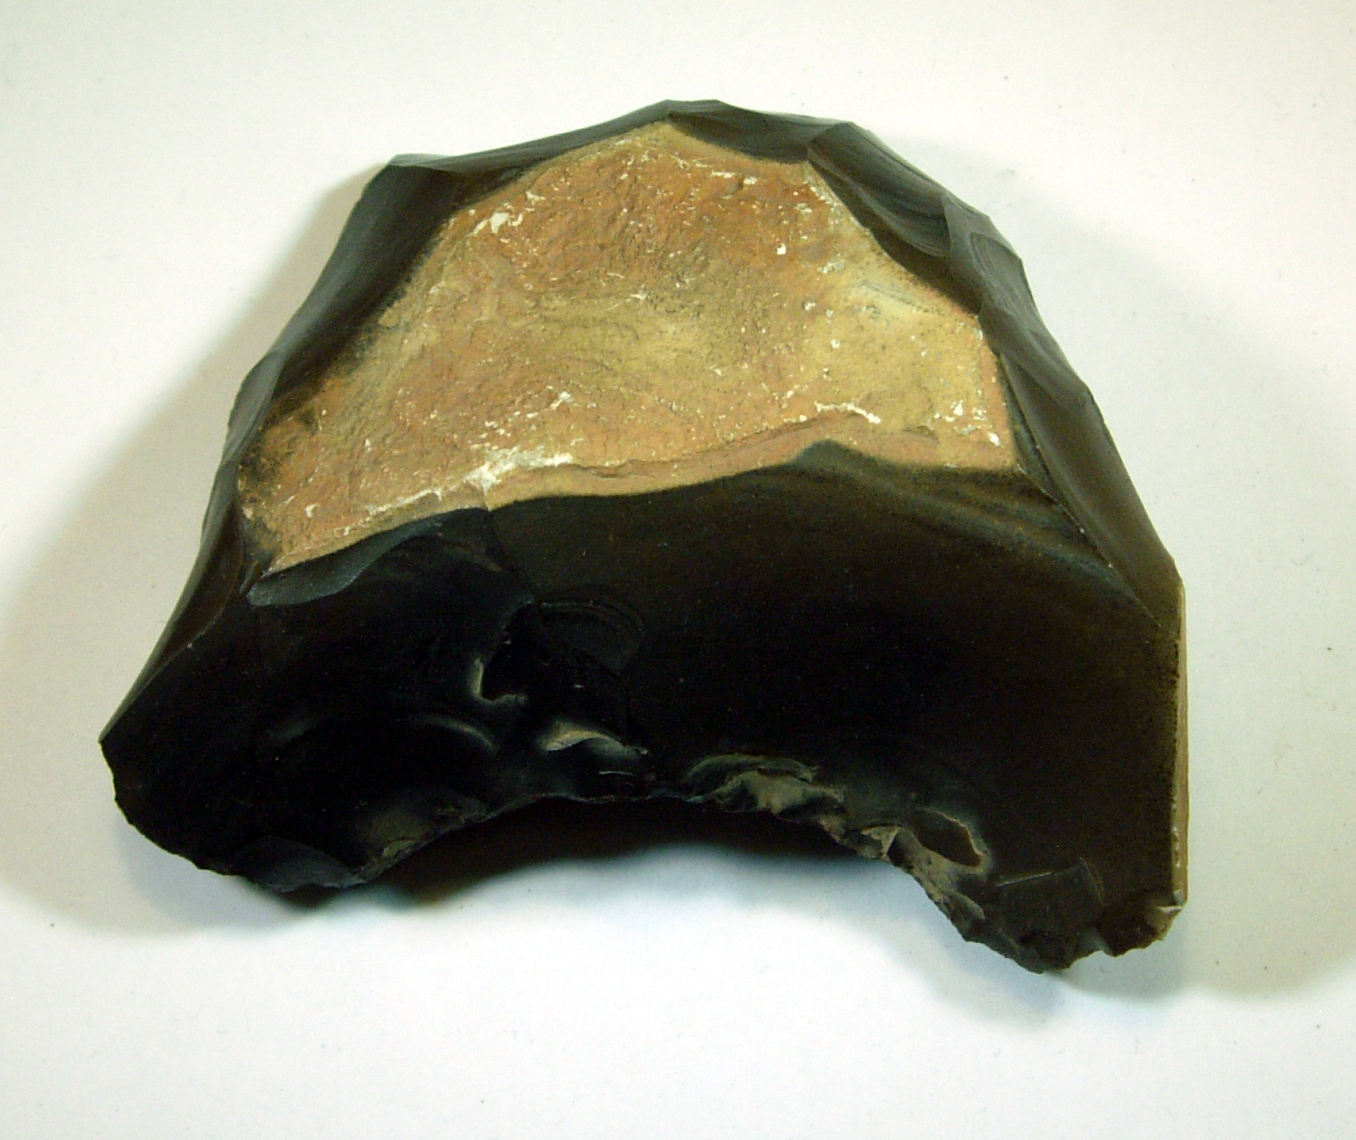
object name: tool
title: Tool (?)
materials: stone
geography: egypt